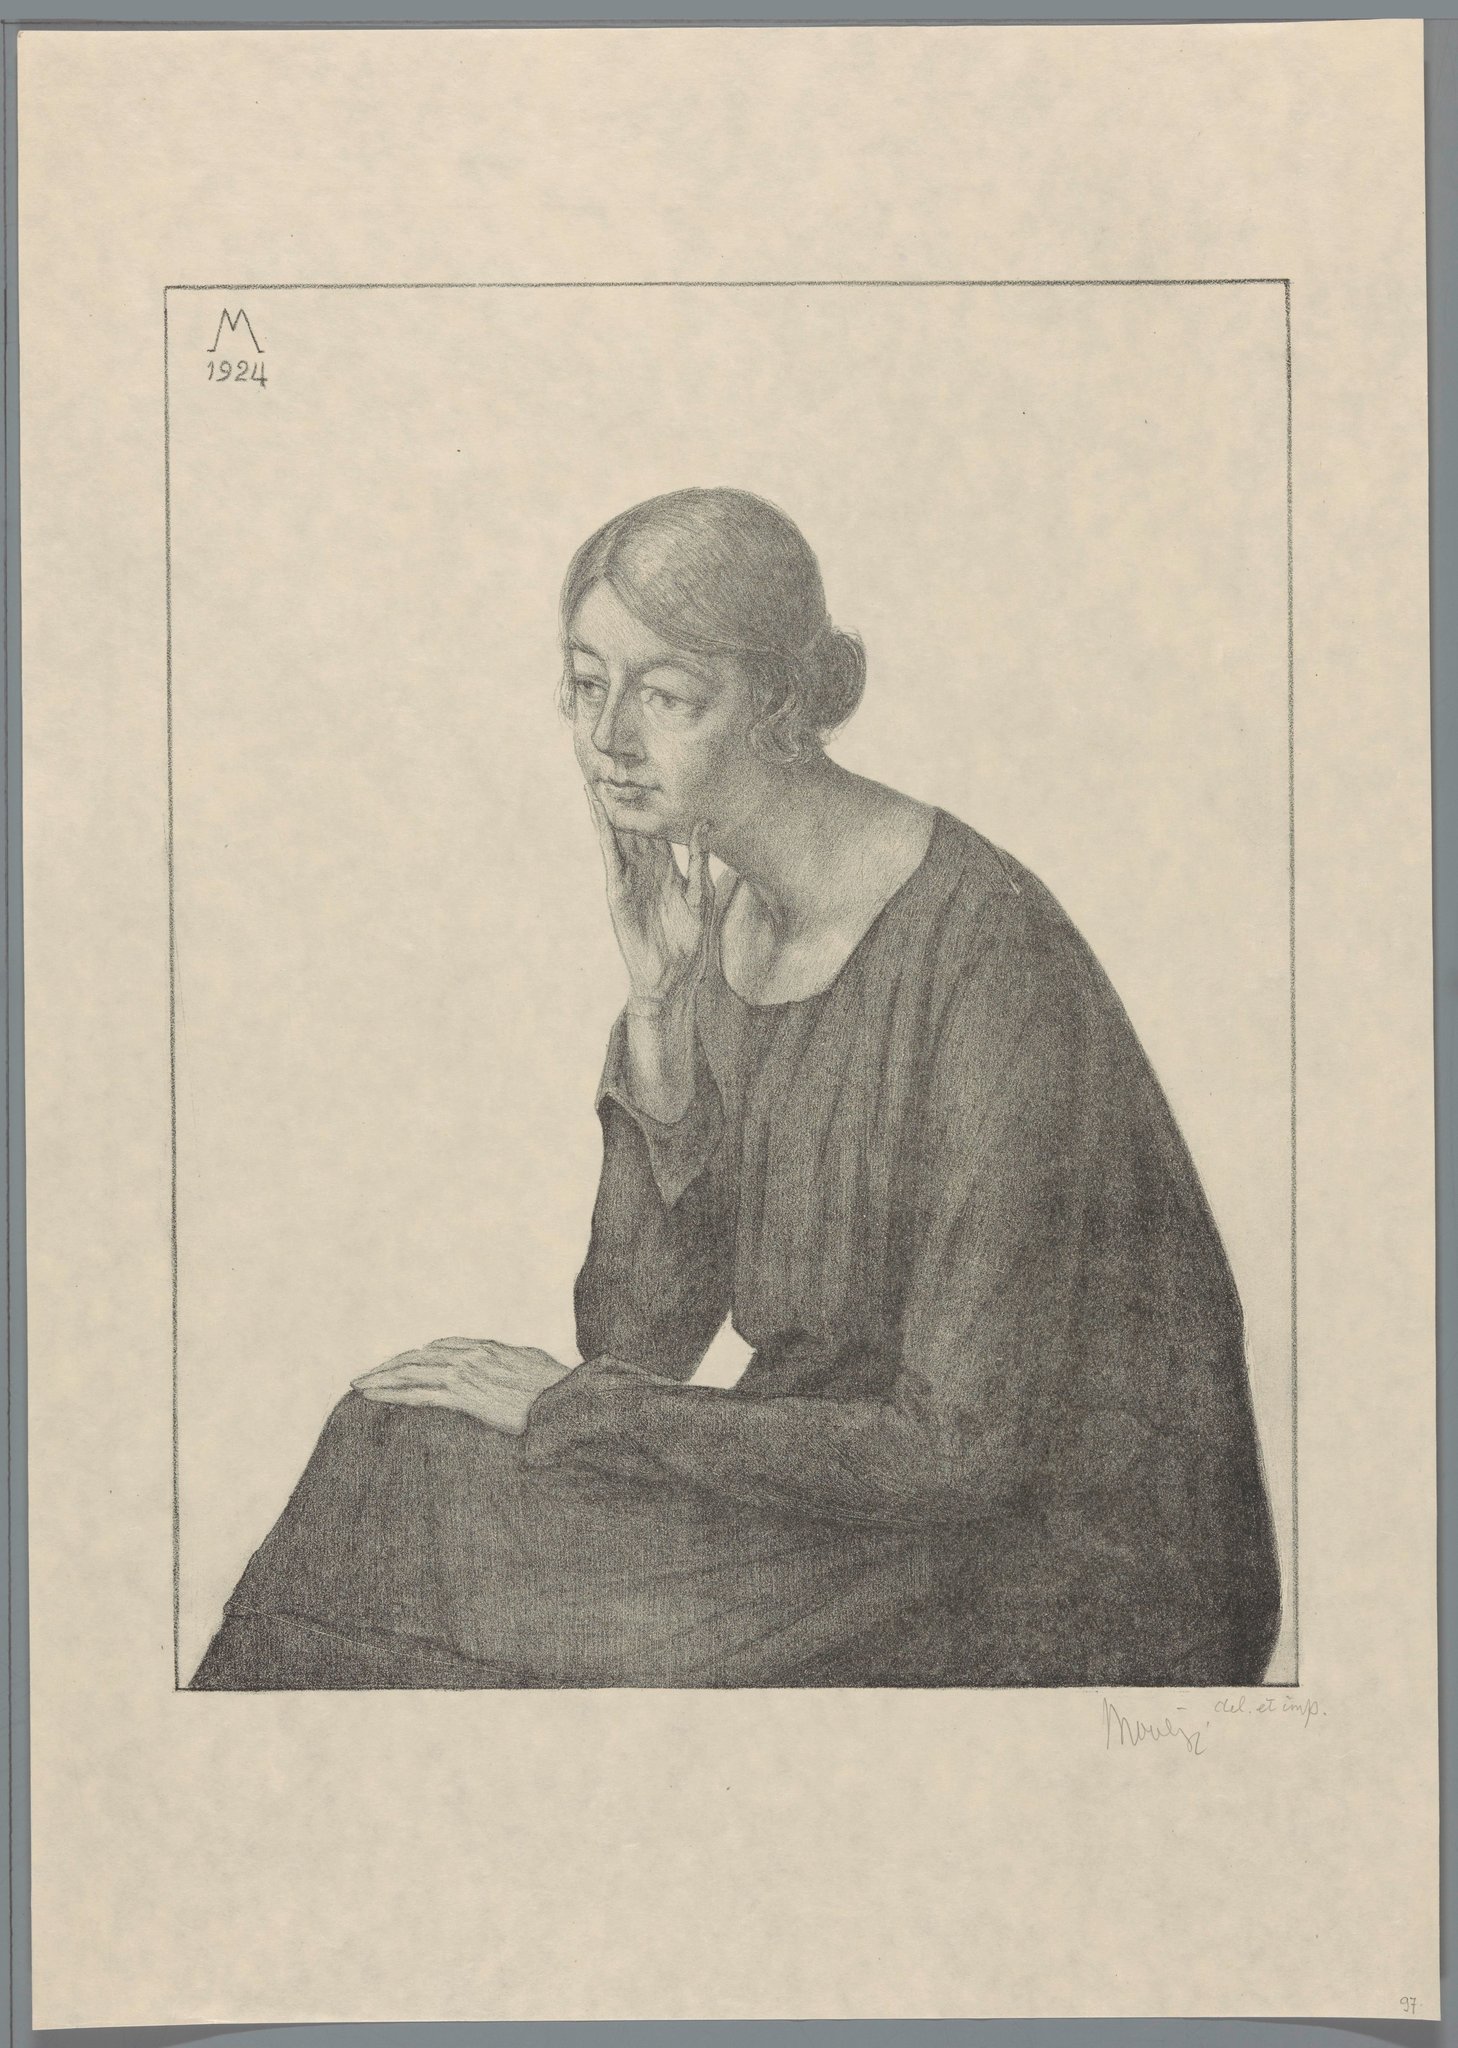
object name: print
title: Portret van Henriëtte Haitsma Mulier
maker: simon moulijn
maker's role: draughtsman, print maker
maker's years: 1866-1948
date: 1924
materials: paper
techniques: lithograph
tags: adult woman, historical persons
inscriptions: collector's mark: Lugt 2228